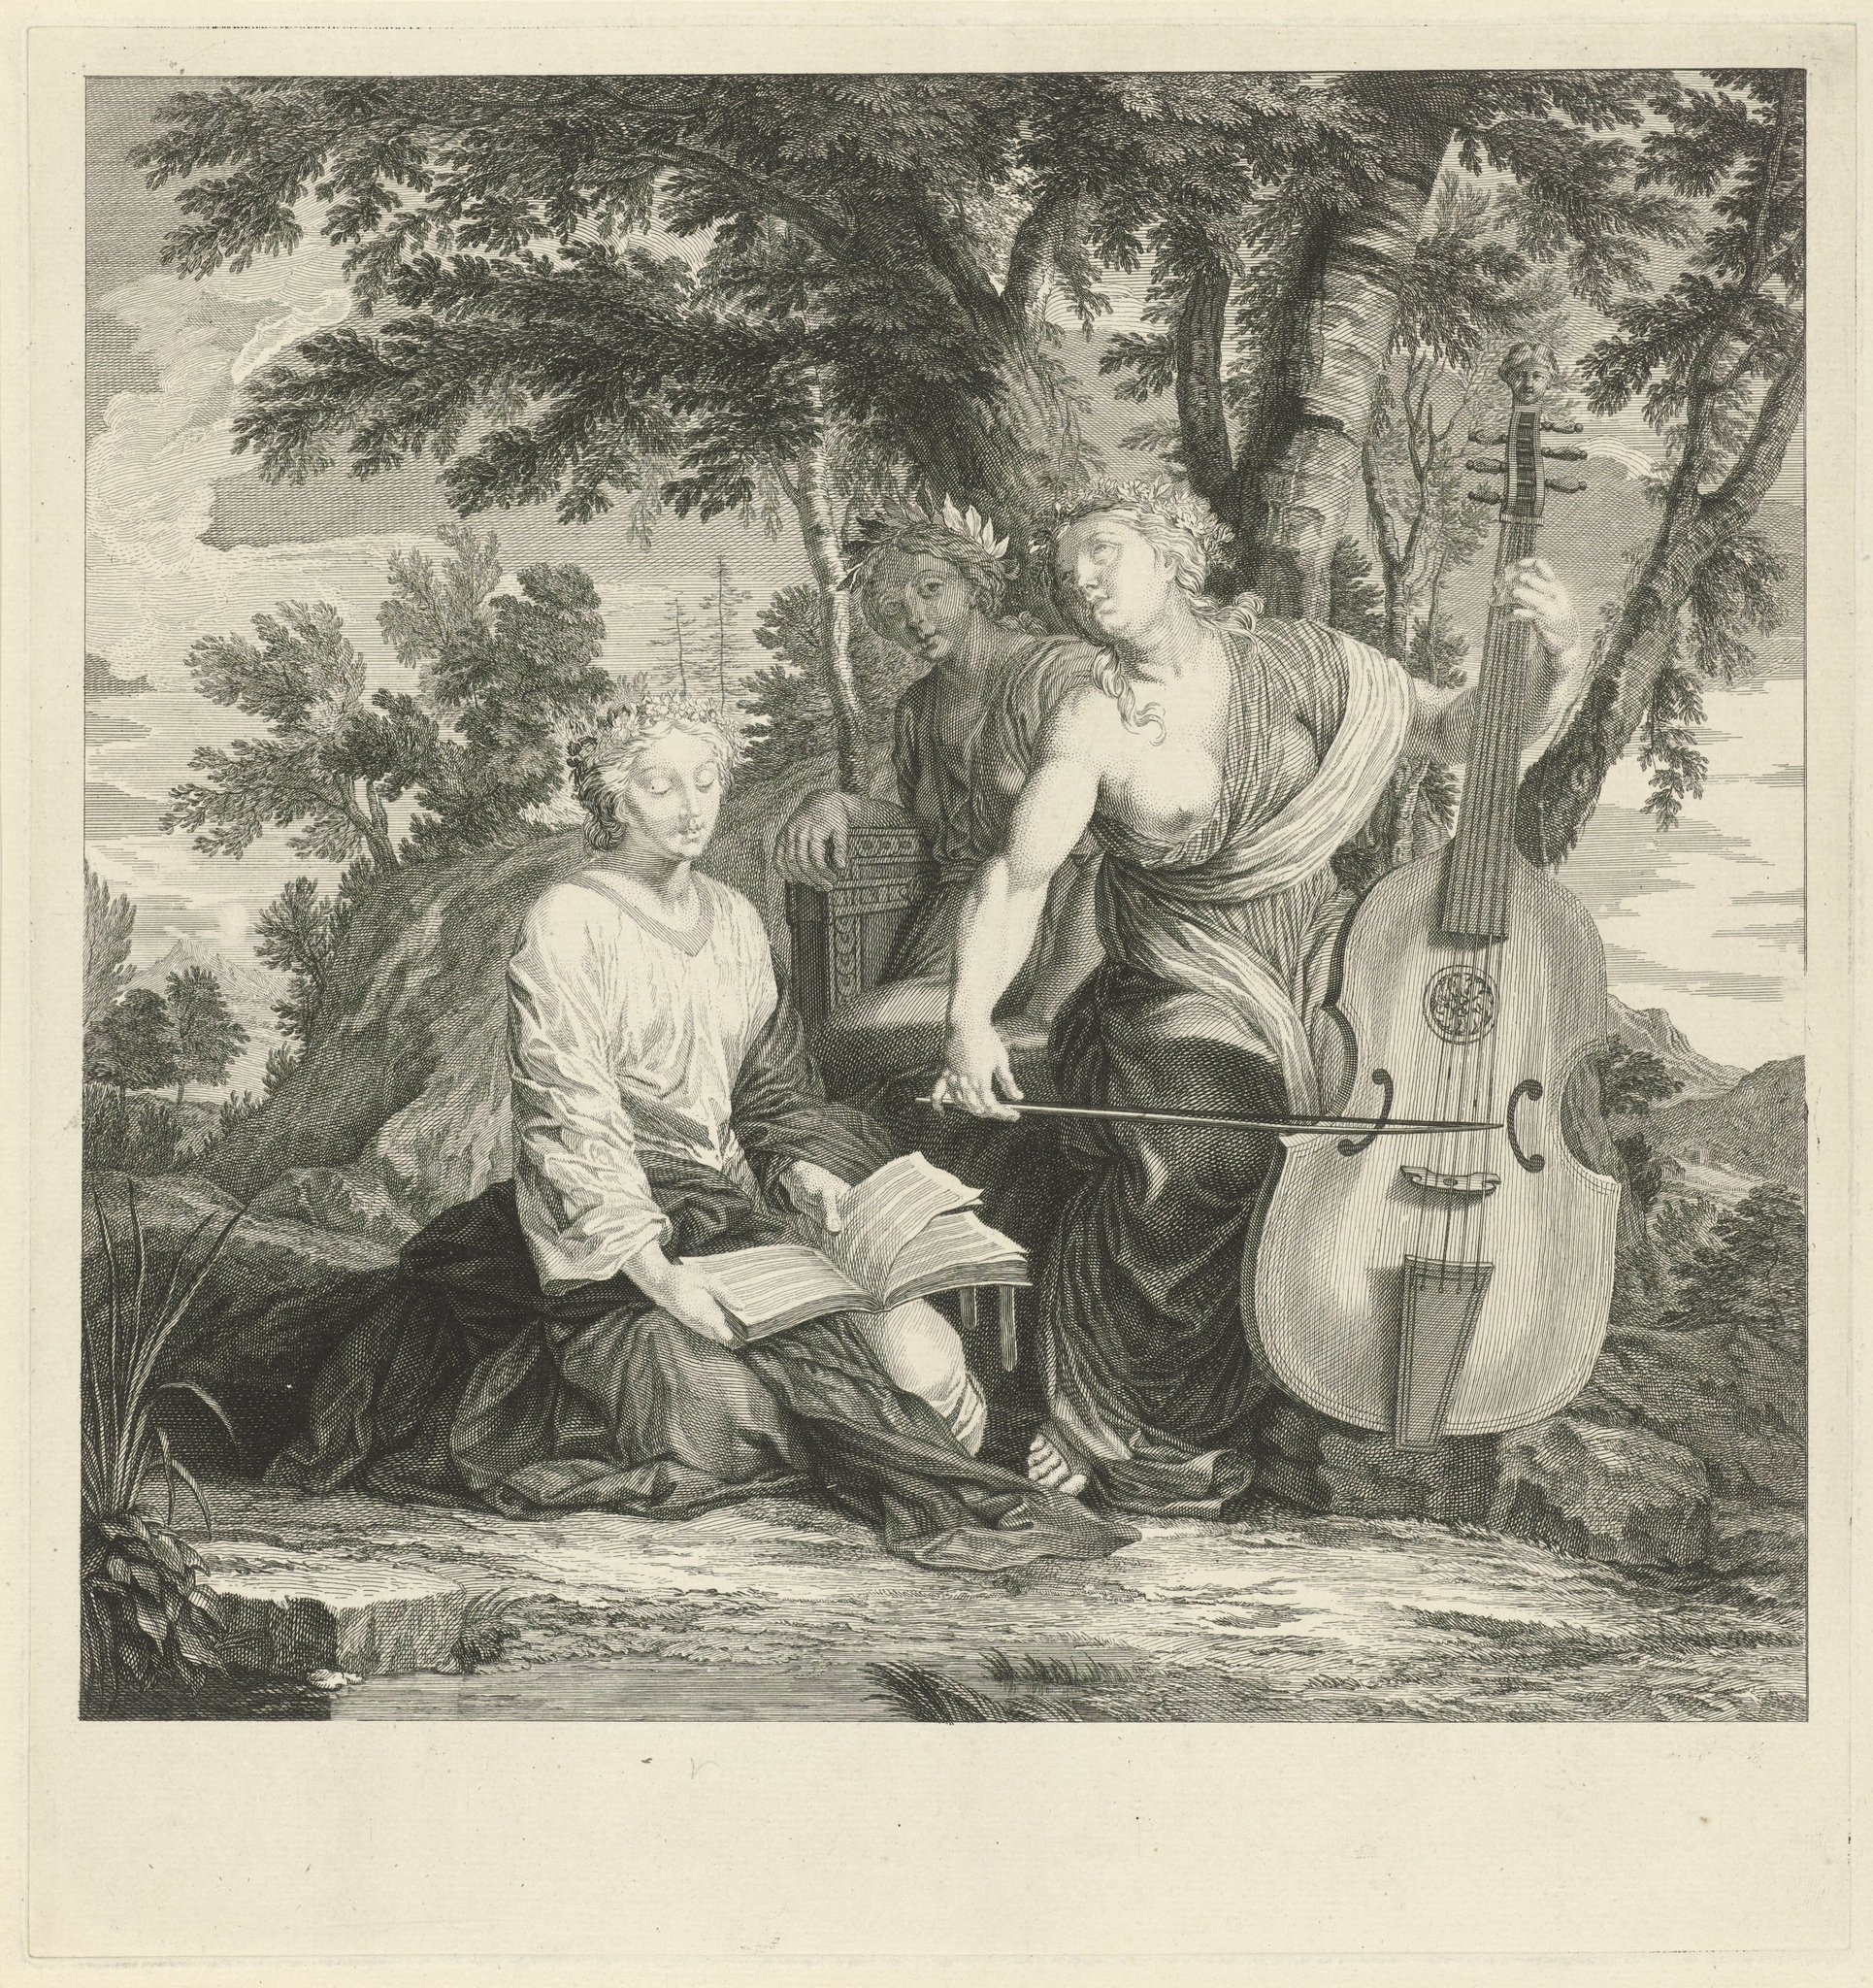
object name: print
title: Landschap met drie musicerende muzen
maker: bernard picart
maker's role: draughtsman, print maker, publisher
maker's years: 1673-1733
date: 1683-1733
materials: paper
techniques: engraving, etching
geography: paris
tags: printed edition of musical score - cc - out of doors, (story of the) muses; 'muse' (ripa), viola, violoncello; double bass, vocal music, singing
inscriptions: collector's mark: Lugt 2228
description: Landschap met een muze die de violoncello bespeelt, een muze met een opengeslagen liedboek op schoot en een derde muze. (Melpomene, Polyhymnia en Erato?).